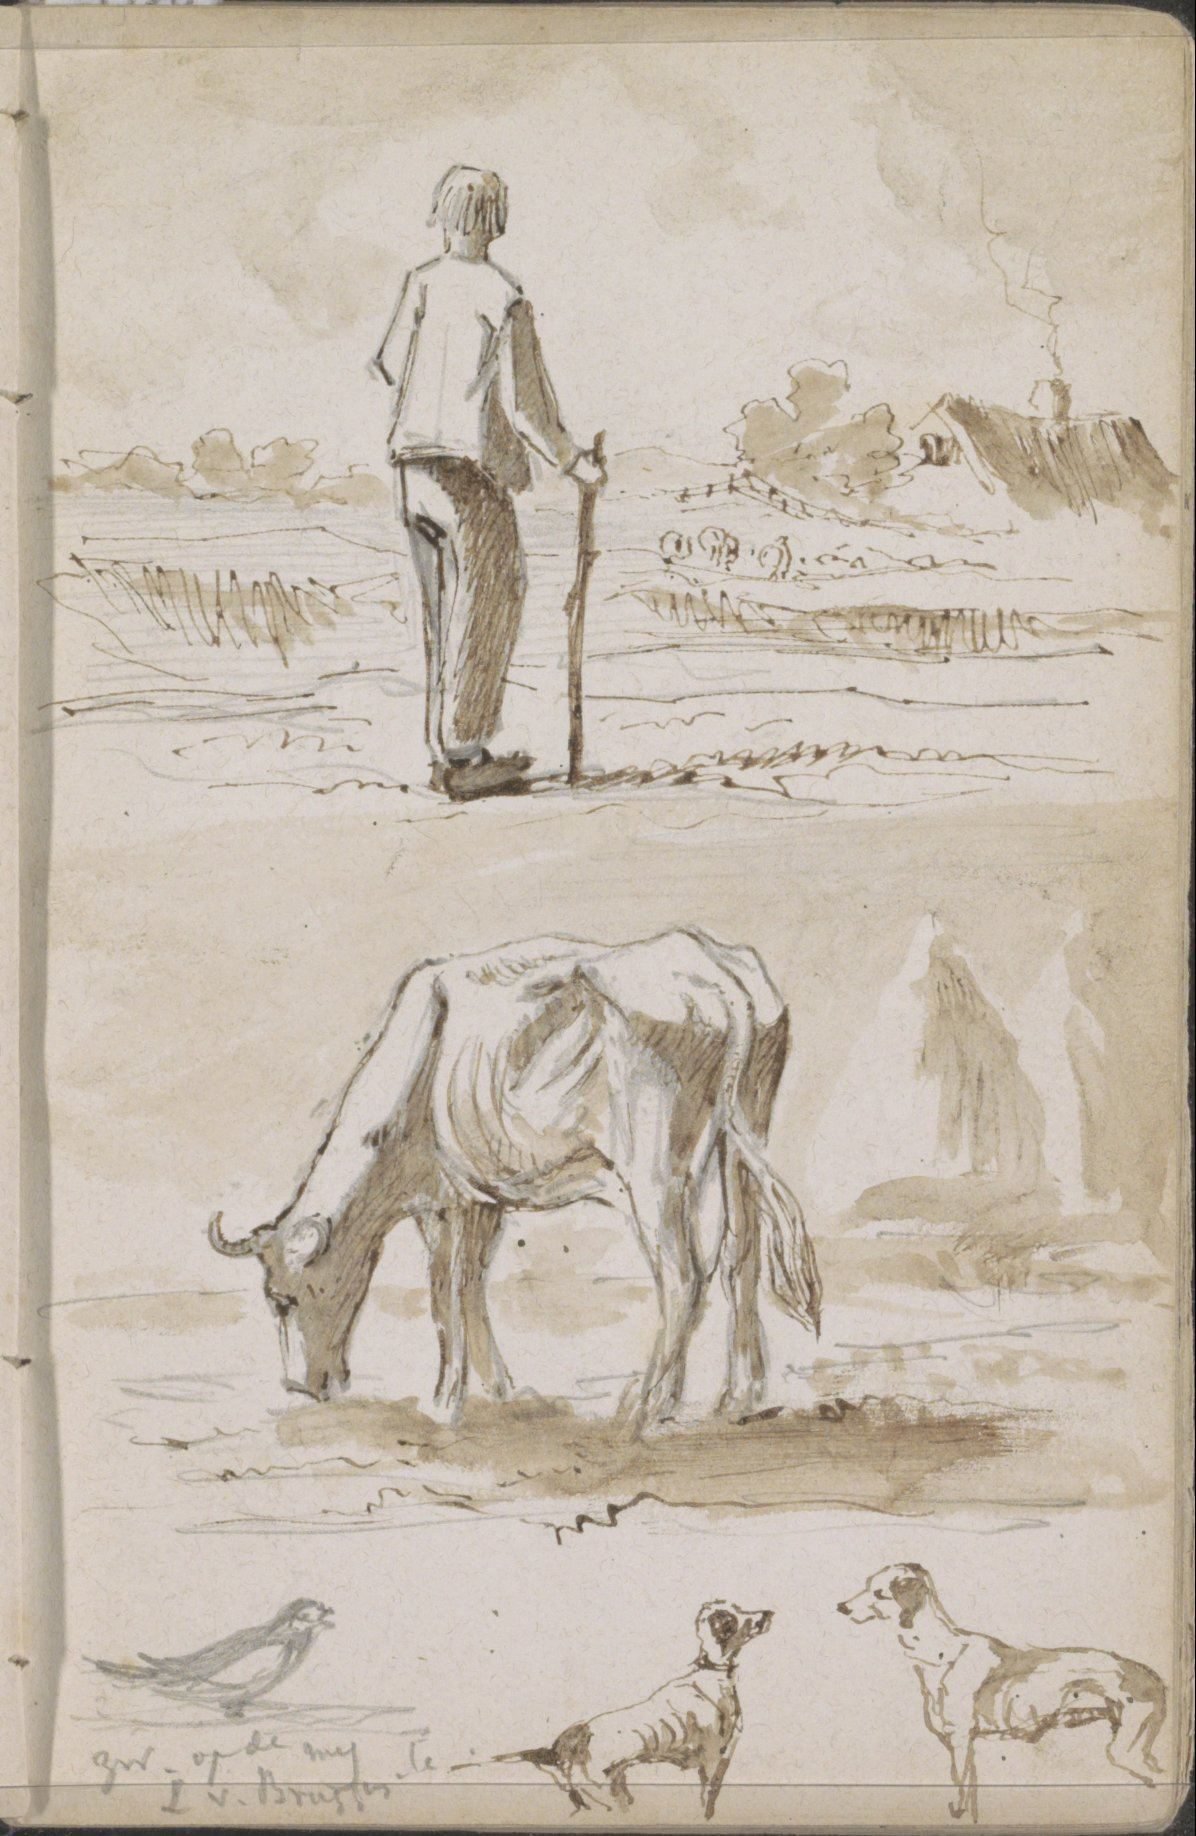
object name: sketchbook leaf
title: Man met een wandelstok en een grazende koe in een landschap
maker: johannes tavenraat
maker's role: draughtsman, painter, print maker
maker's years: 1809-1881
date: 1862-1864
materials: ink, paper, pencil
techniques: brush, pen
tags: cow, birds, walking-stick, staff, landscapes (+ landscape with figures, staffage), dog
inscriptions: annotation: ‘z[...] op de w[...]y/ I v. Bruggen de’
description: Tevens studies van honden en een vogel. Blad 15 recto uit een schetsboek met 65 bladen.